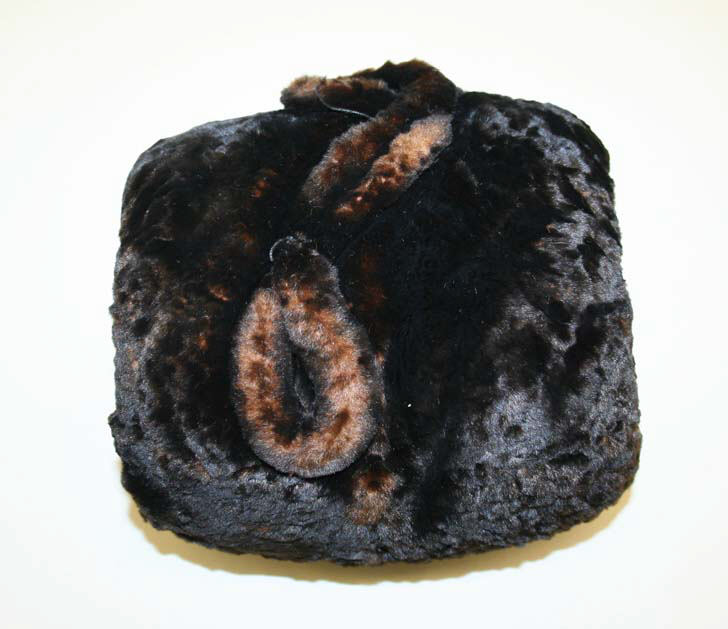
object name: muff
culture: american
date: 1895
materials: fur